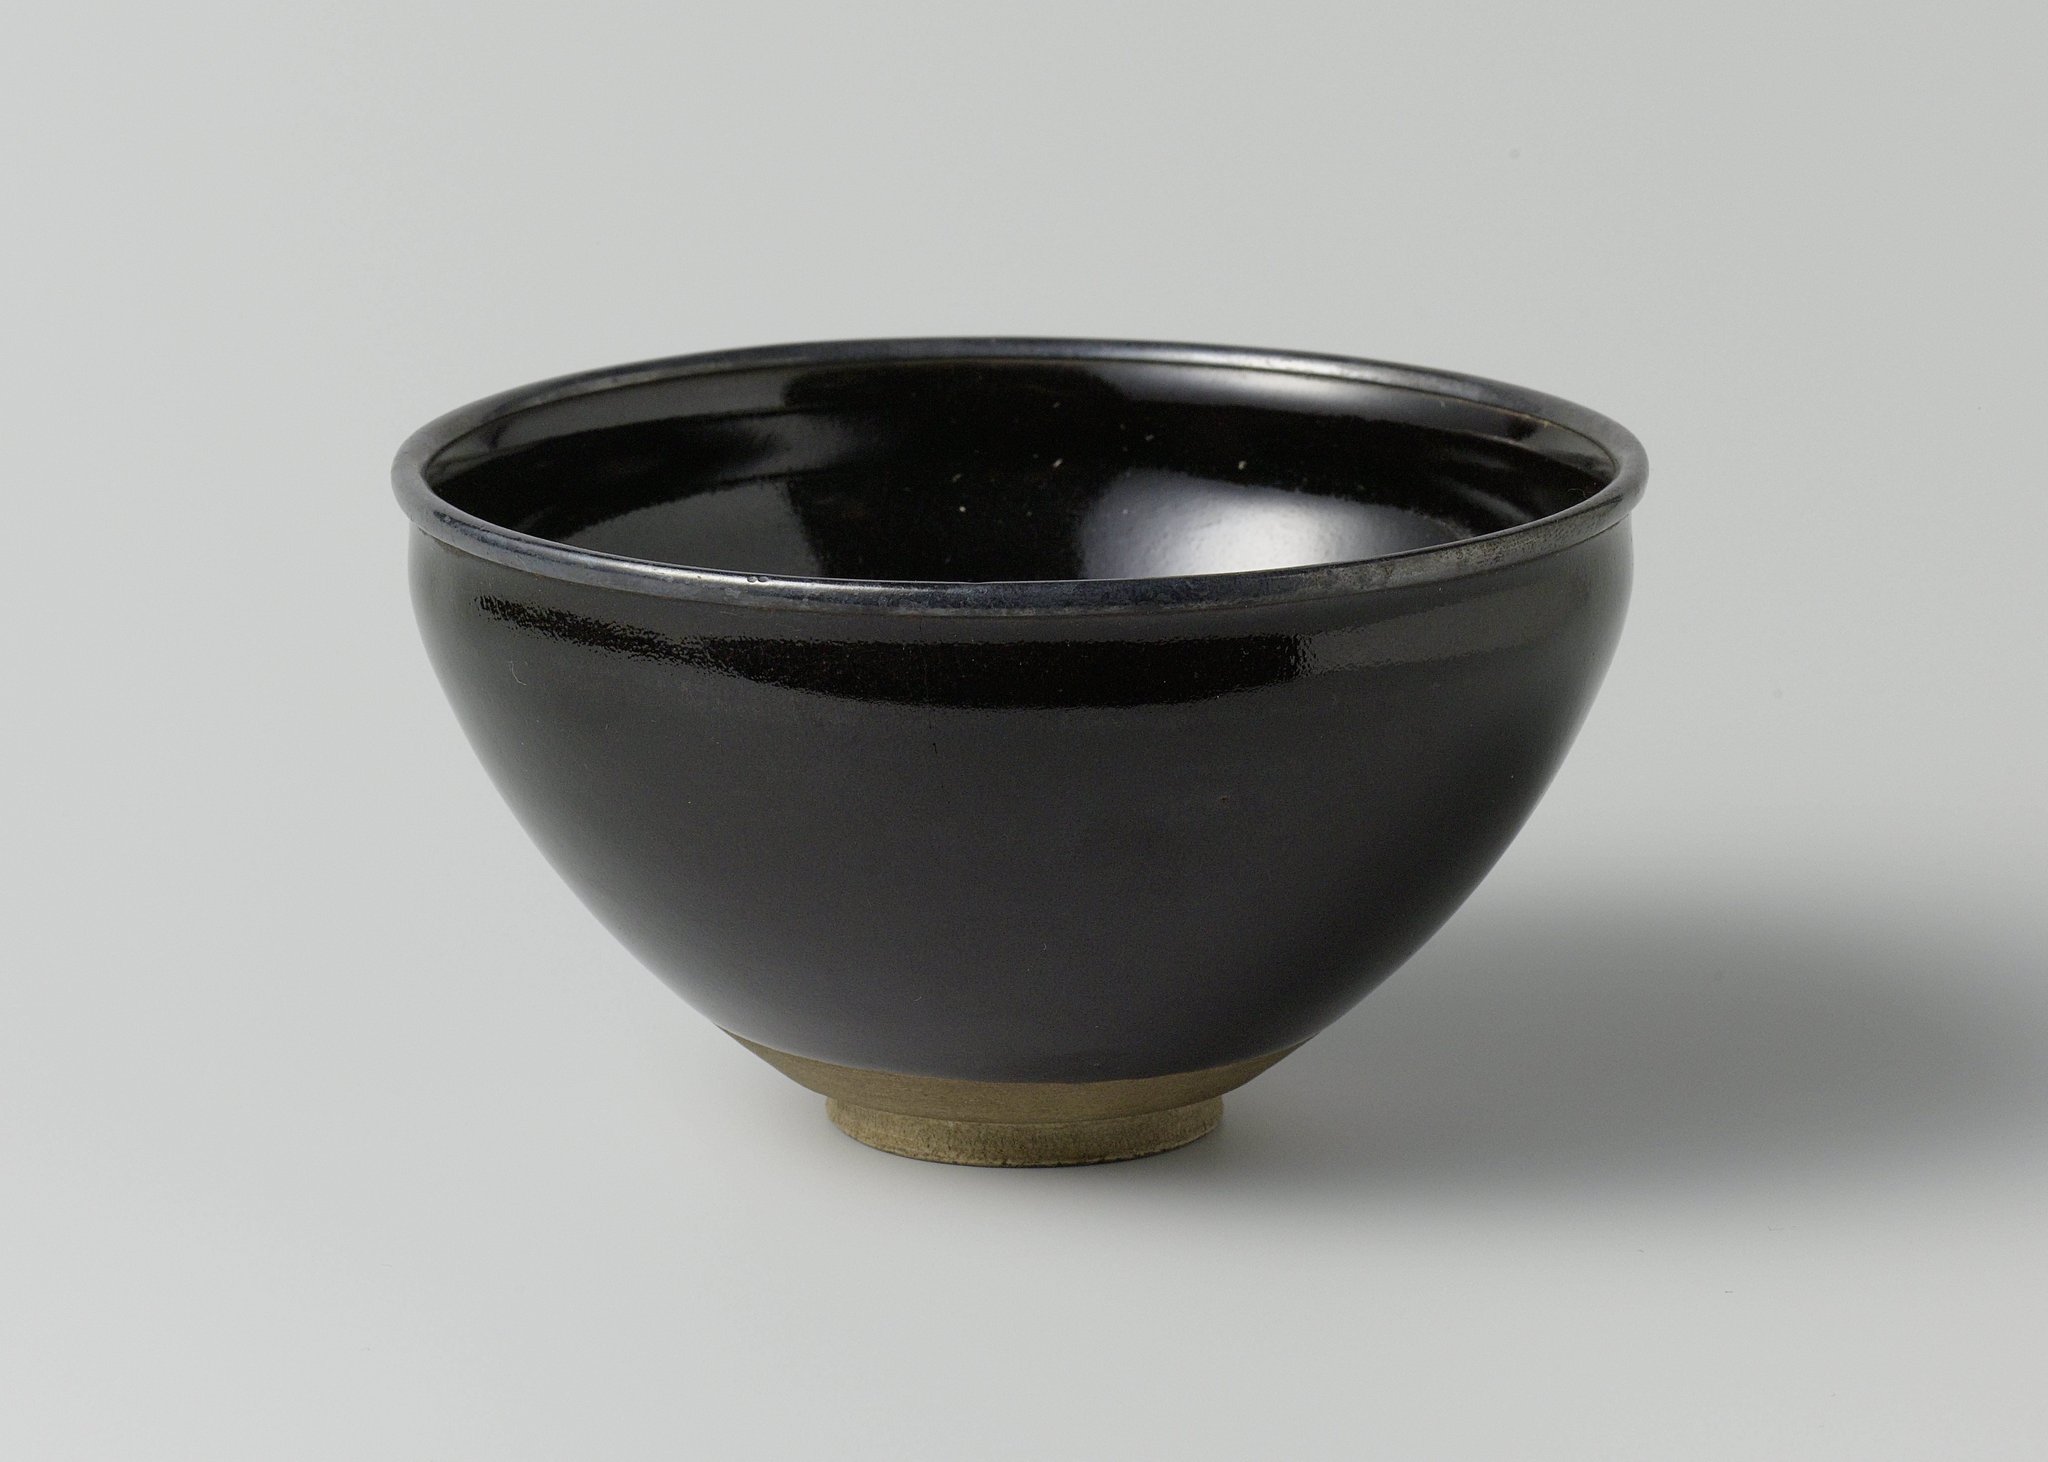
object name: tea bowl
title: Tea bowl with a brownish black glaze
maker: arthur lonsdale hetherington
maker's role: auteur, verzamelaar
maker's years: 1881-1961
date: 1900-1968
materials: glaze, metal, stoneware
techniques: firing, turning, vitrification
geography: great britain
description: Theekom van steengoed, gedeeltelijk bedekt met een bruinzwart glazuur. De onderste helft van de kom is ongeglazuurd. De rand is gevat in een metalen band. Engelse imitatie van een Chinese temmoku kom.